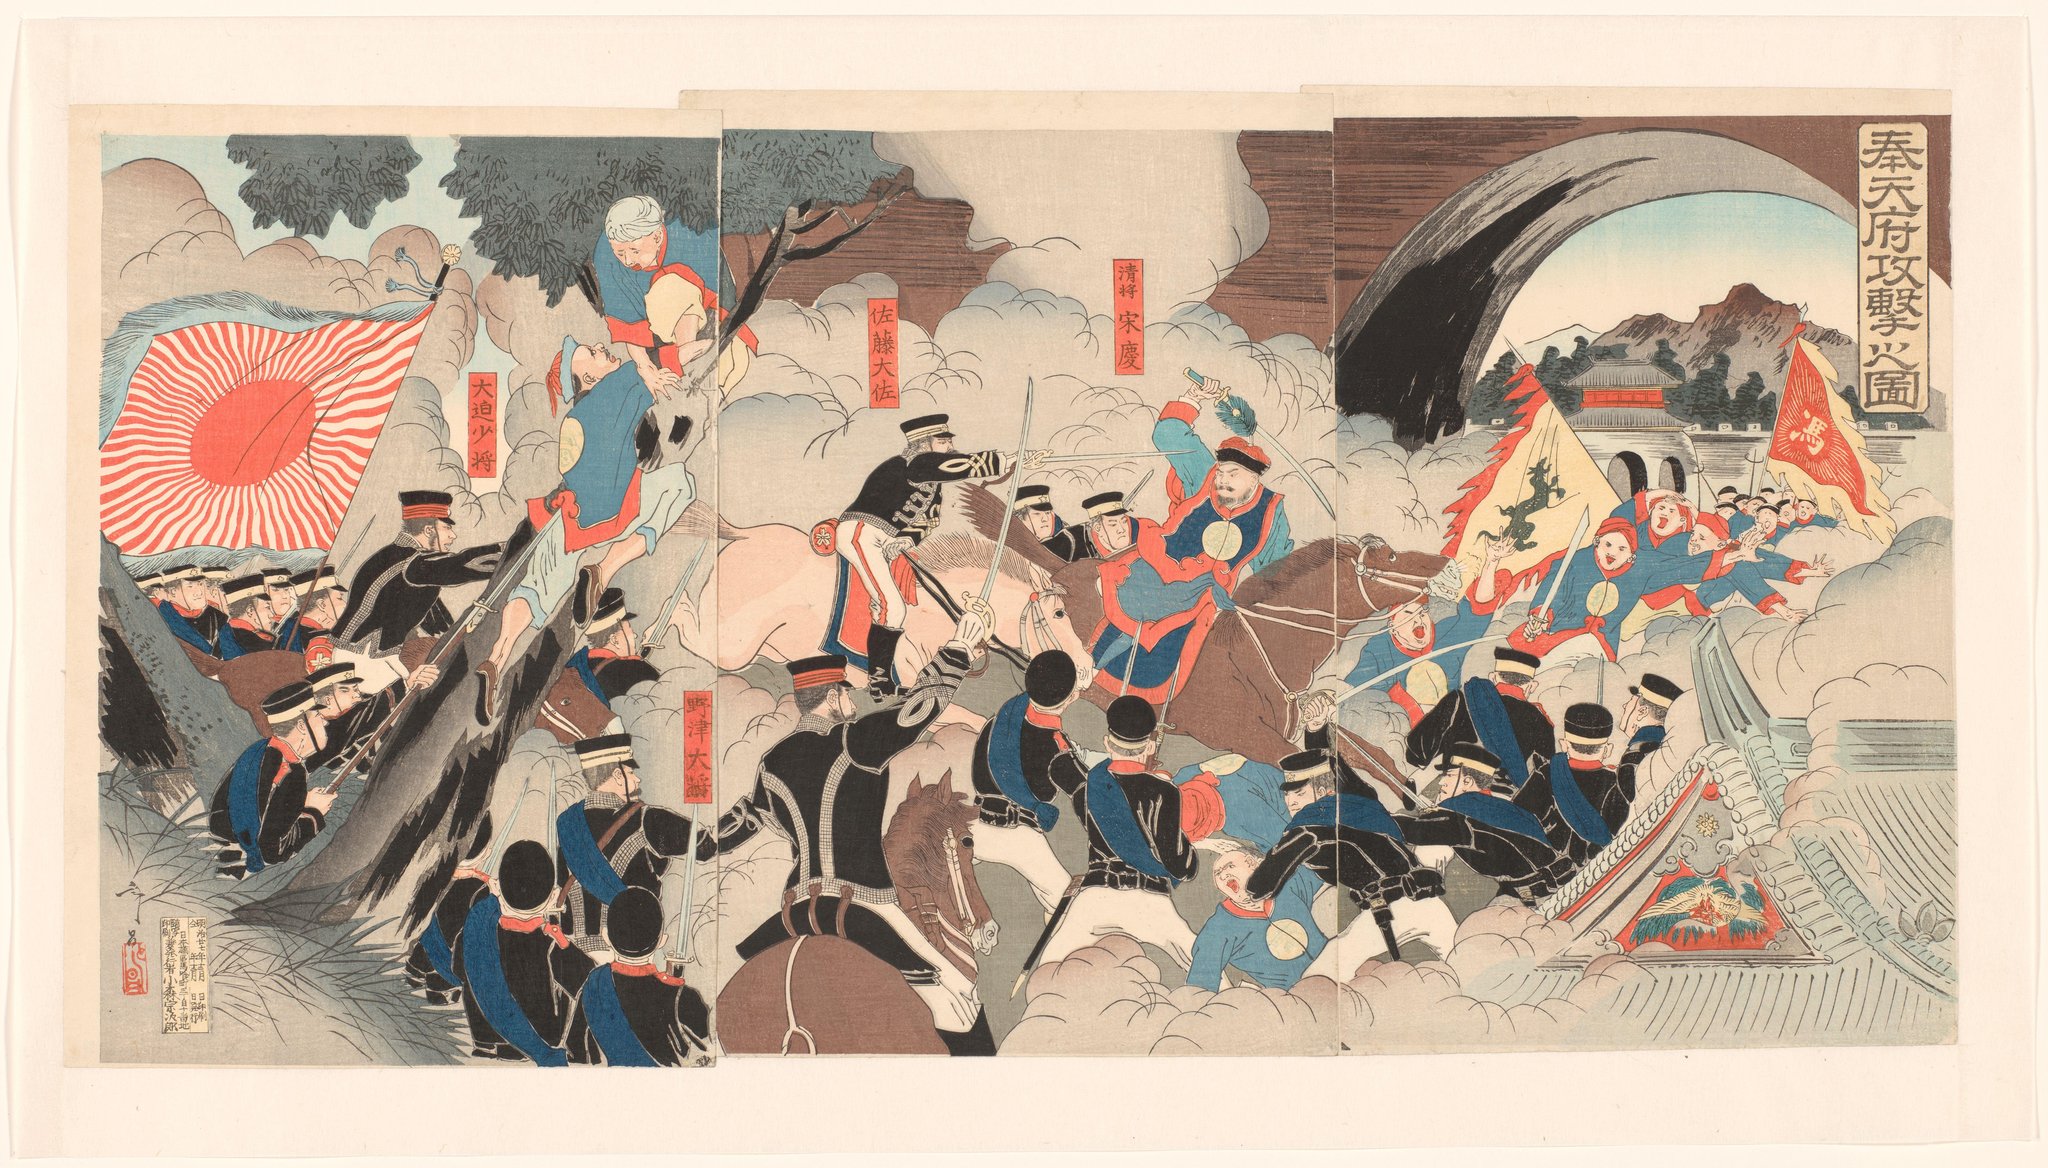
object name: print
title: Japanse oorlogsprent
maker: Anonymous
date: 1894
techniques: woodcut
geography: japan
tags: war